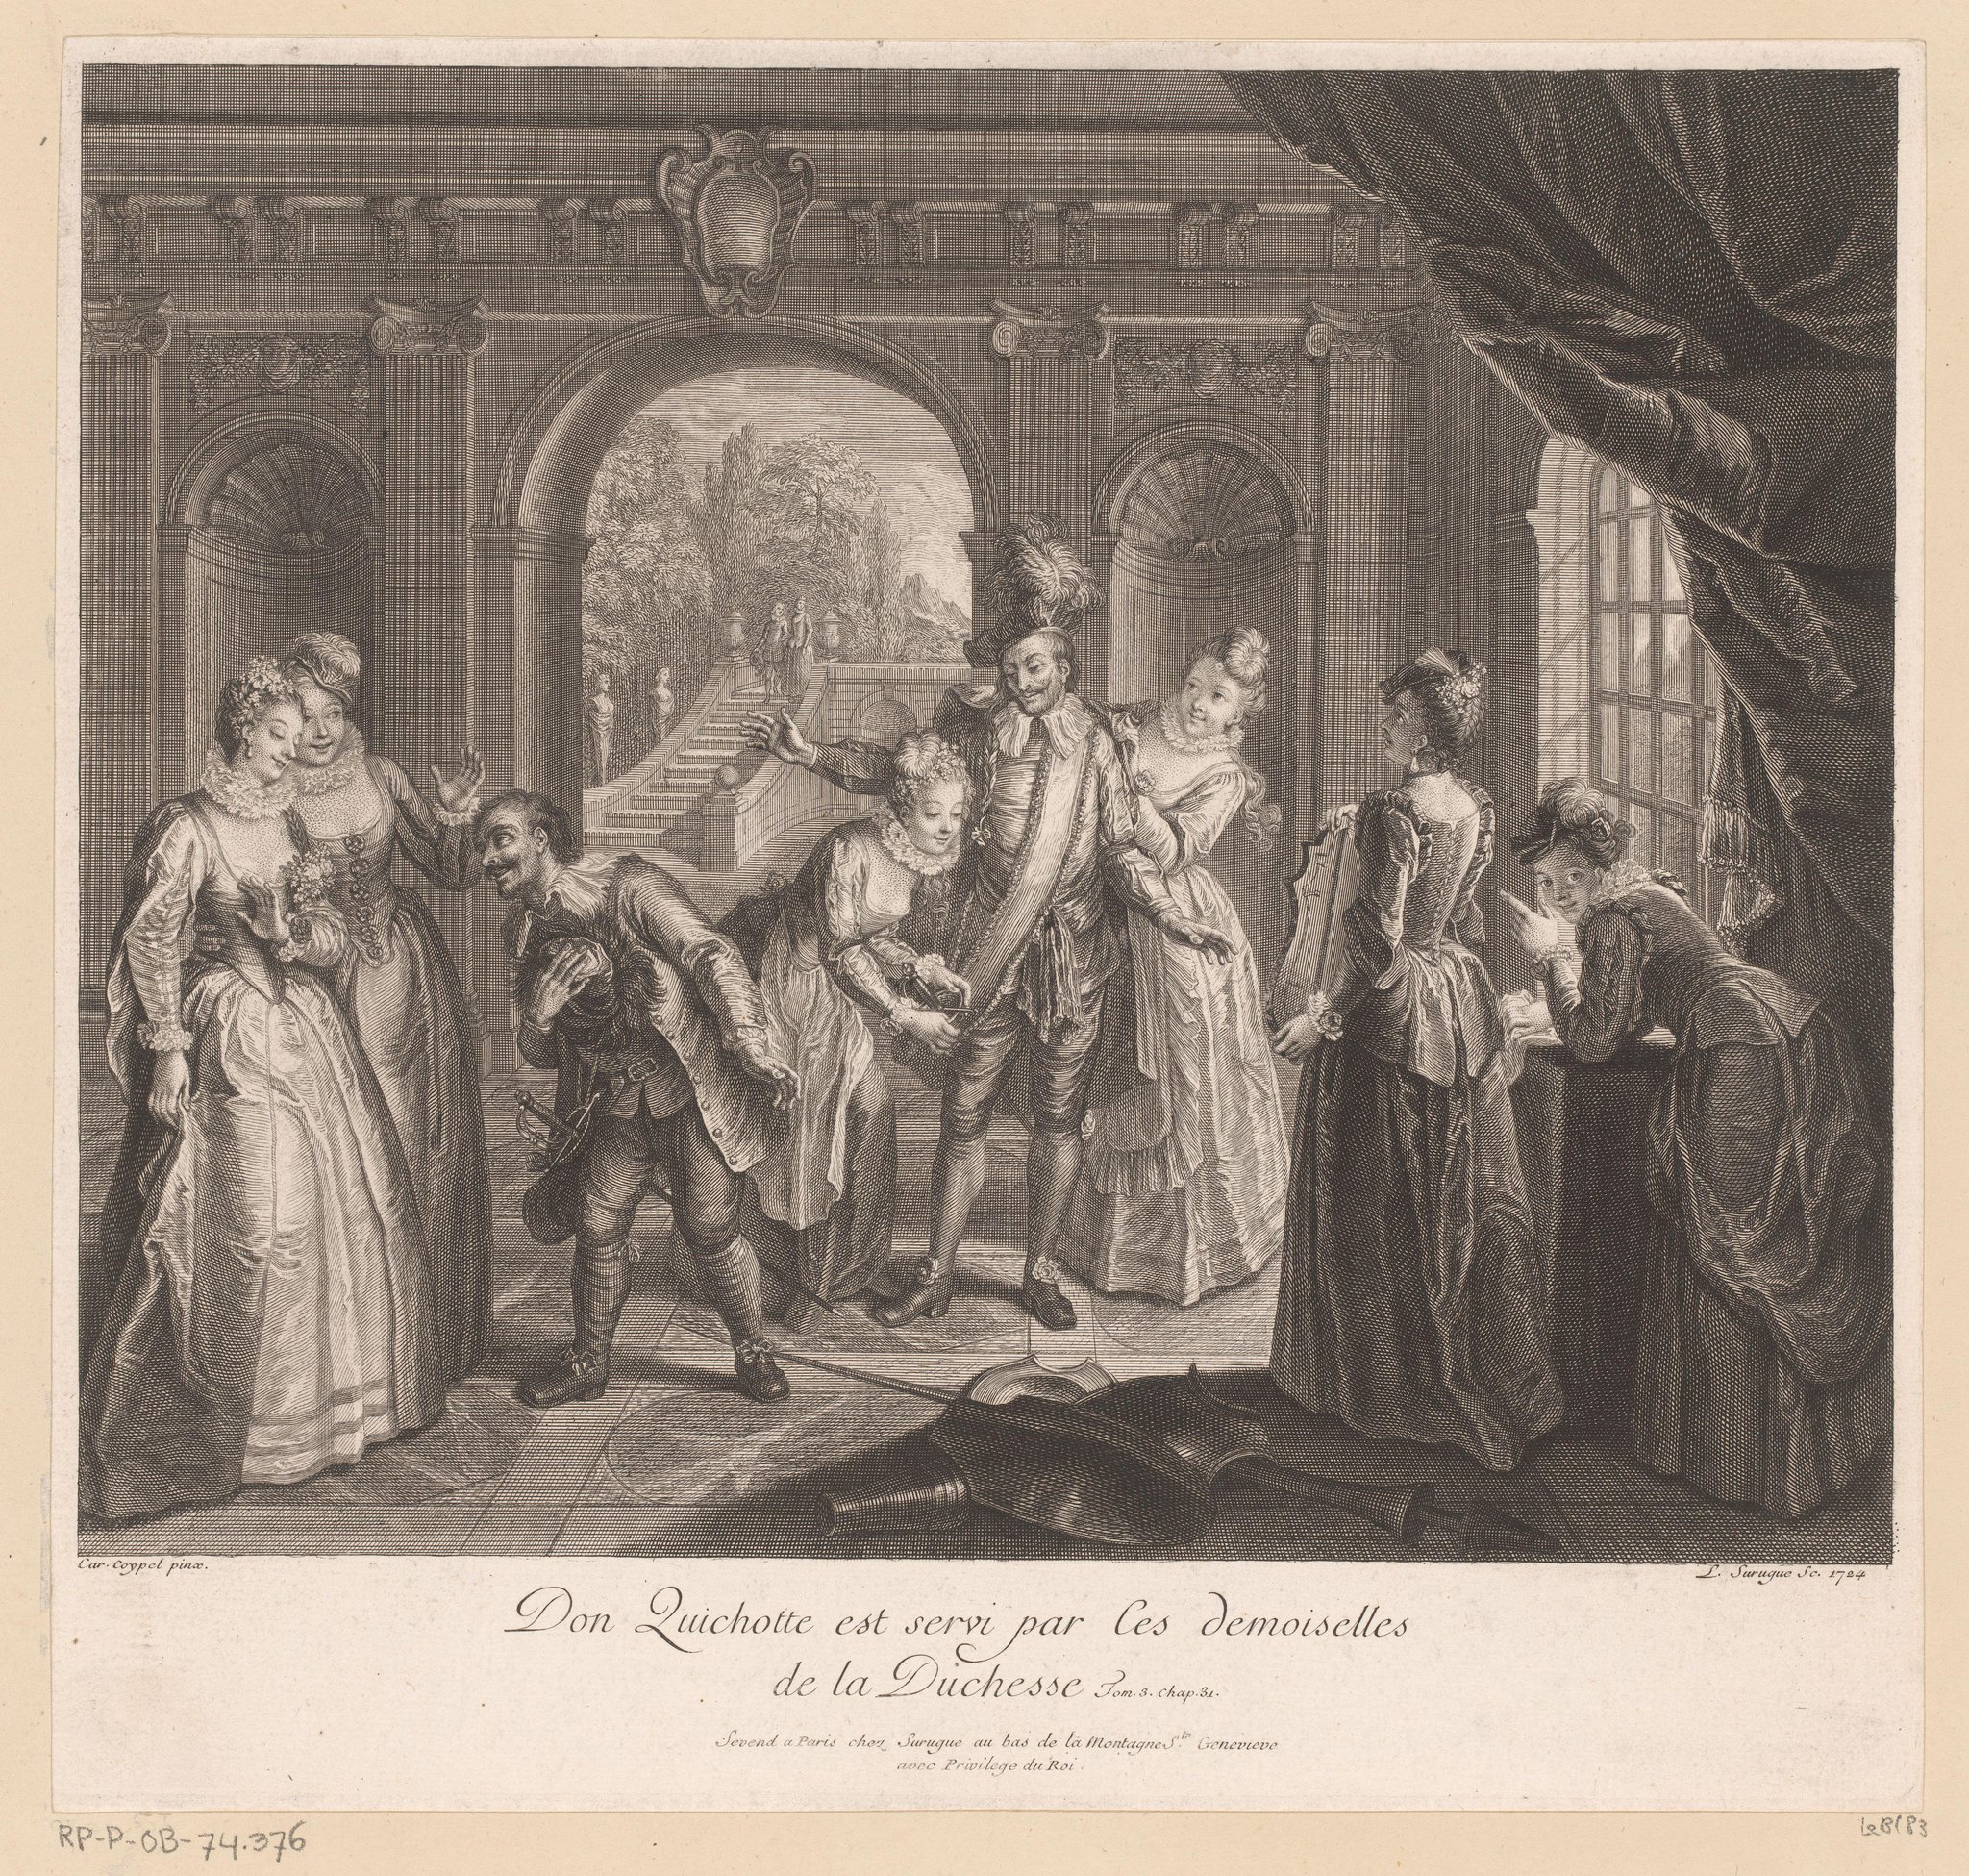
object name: print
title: Gechiedenis van Don Quichot van La Mancha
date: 1724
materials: paper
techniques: engraving, etching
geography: paris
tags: don quixote, sancho panza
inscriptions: collector's mark: Lugt 240